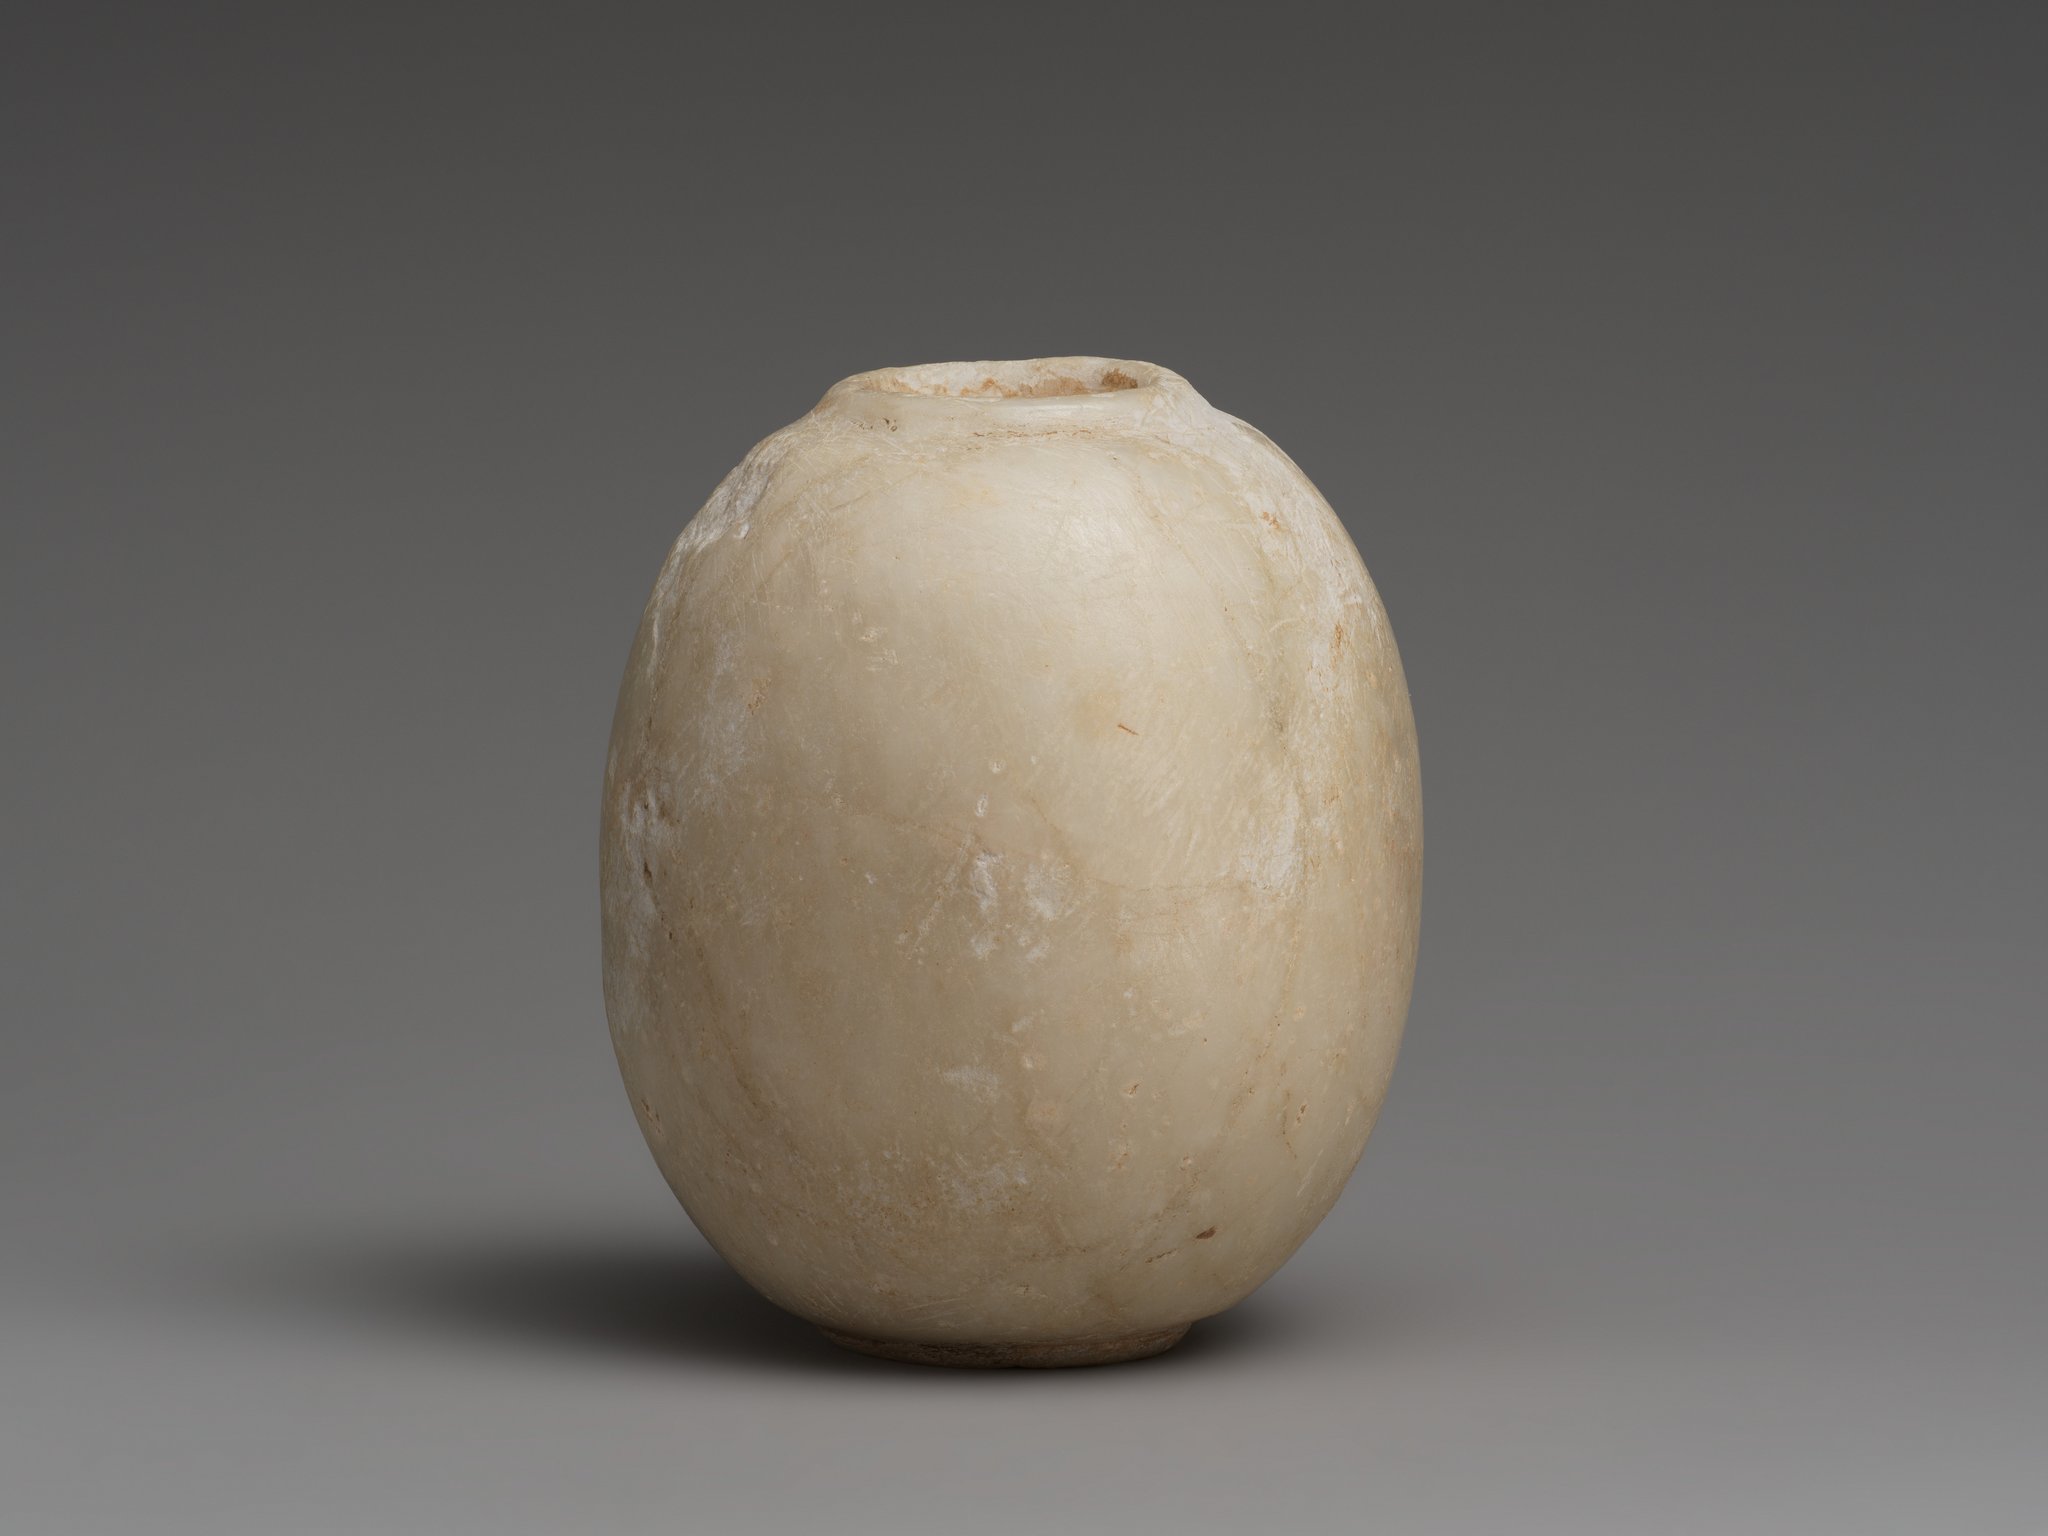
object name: mace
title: Mace head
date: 7000-5001 BCE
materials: stone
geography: syria